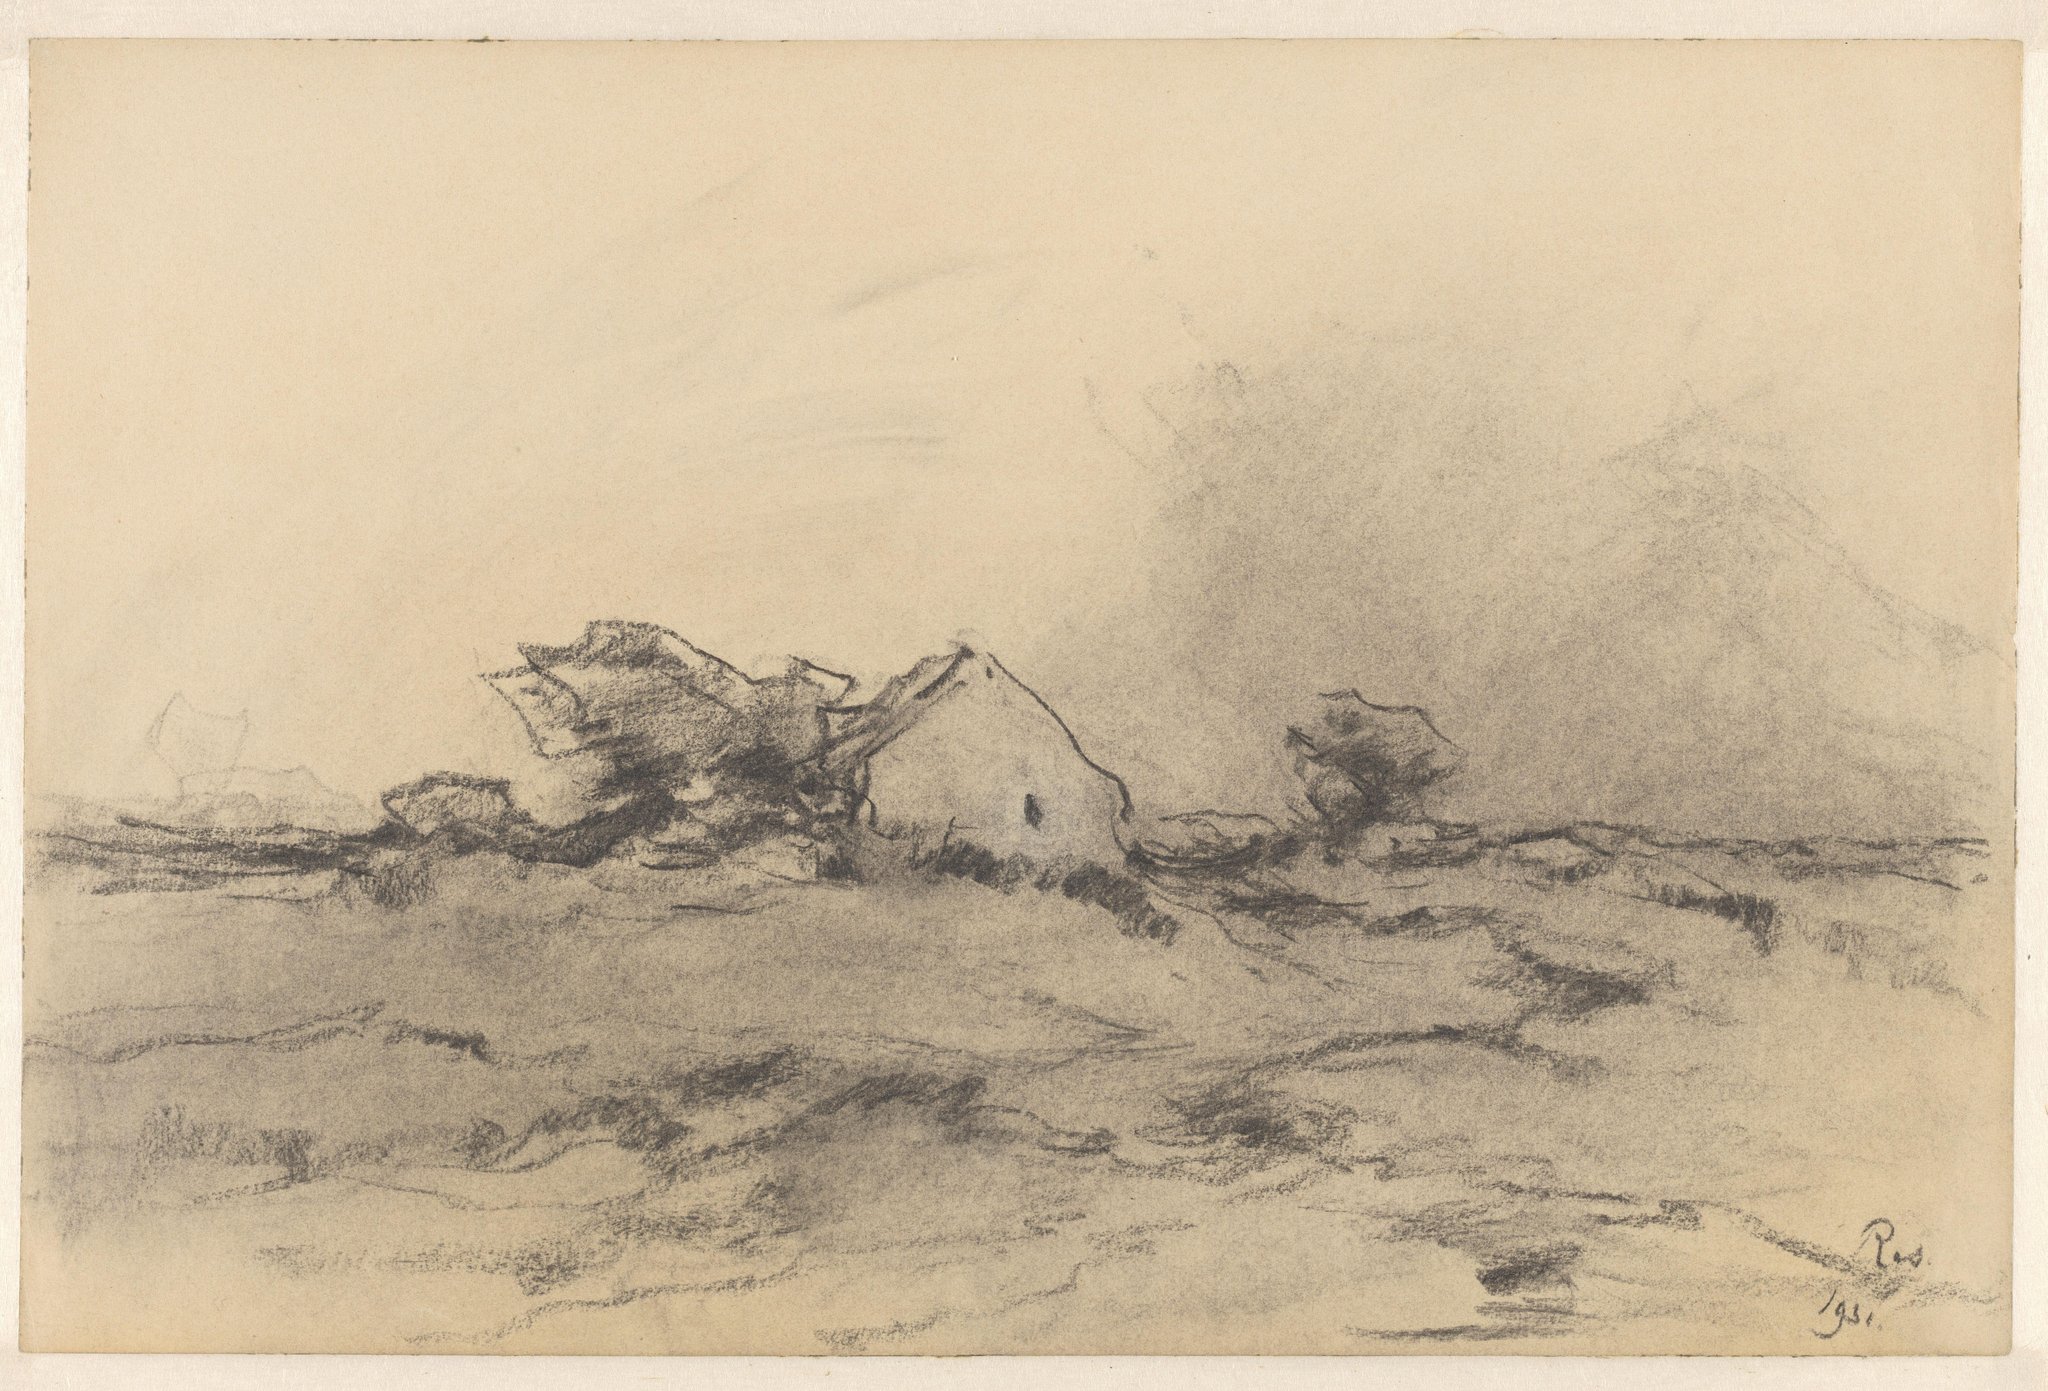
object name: drawing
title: Heidehut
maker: pieter h.j.j. ras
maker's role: draughtsman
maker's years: 1857-1941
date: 1931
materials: chalk, paper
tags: hut, cabin, lodge